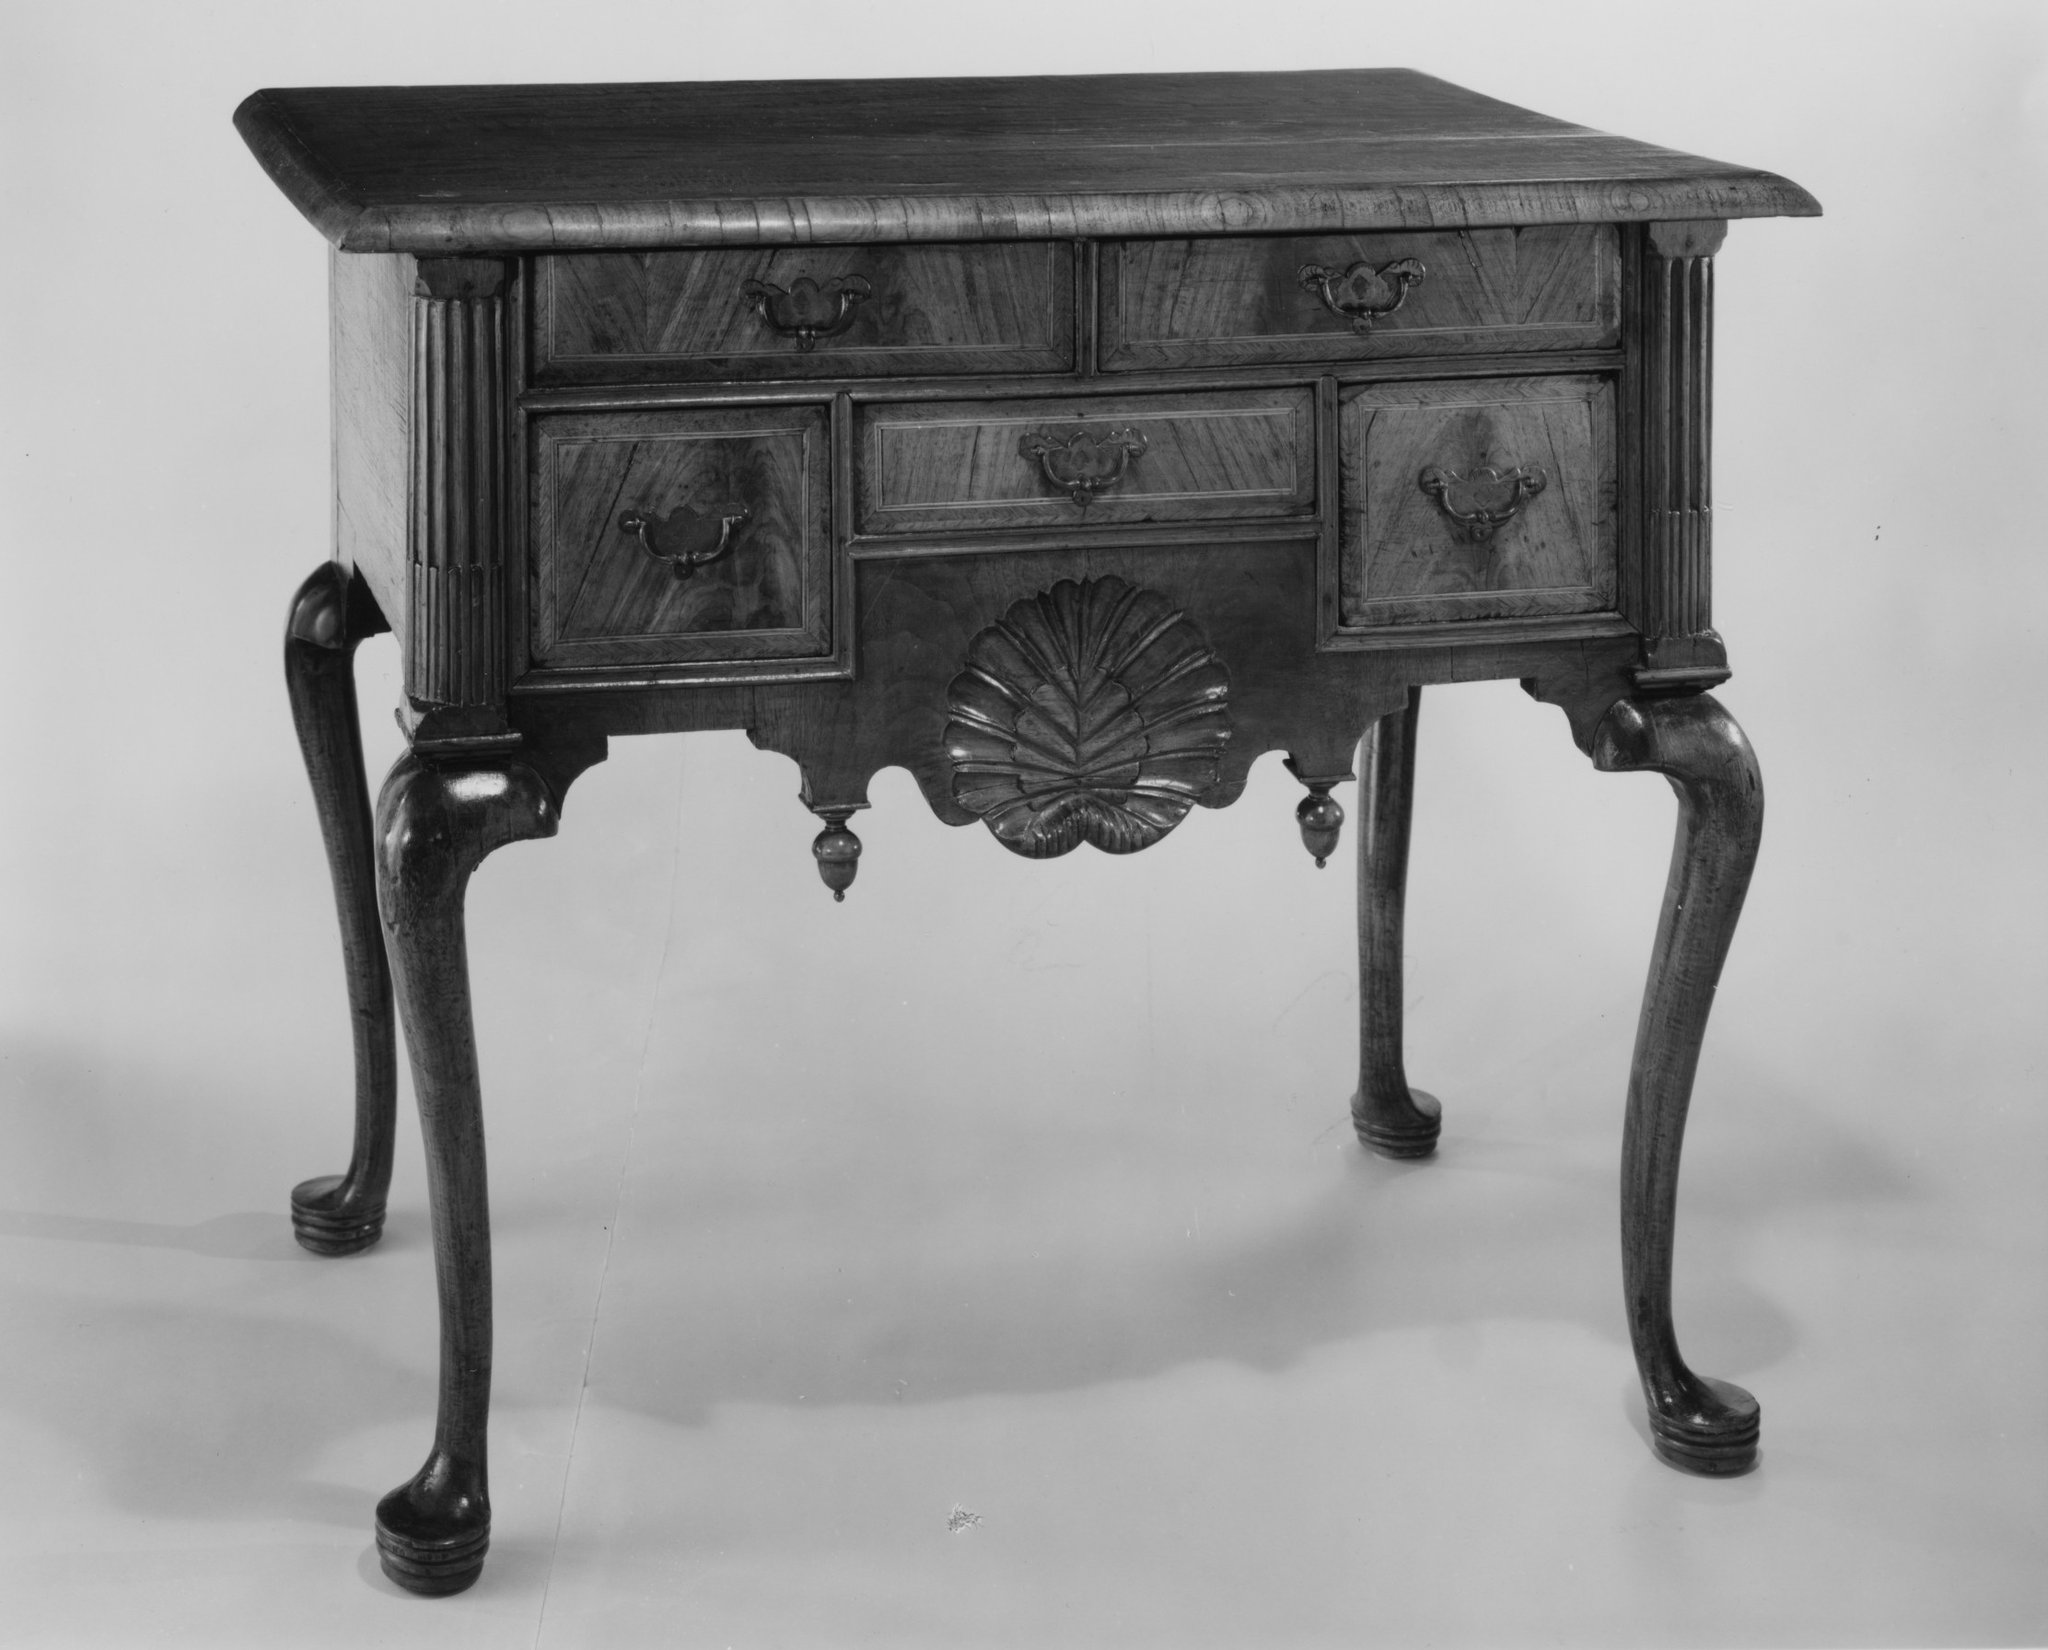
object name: dressing table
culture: american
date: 1730-1750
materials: wood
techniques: veneering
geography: united states